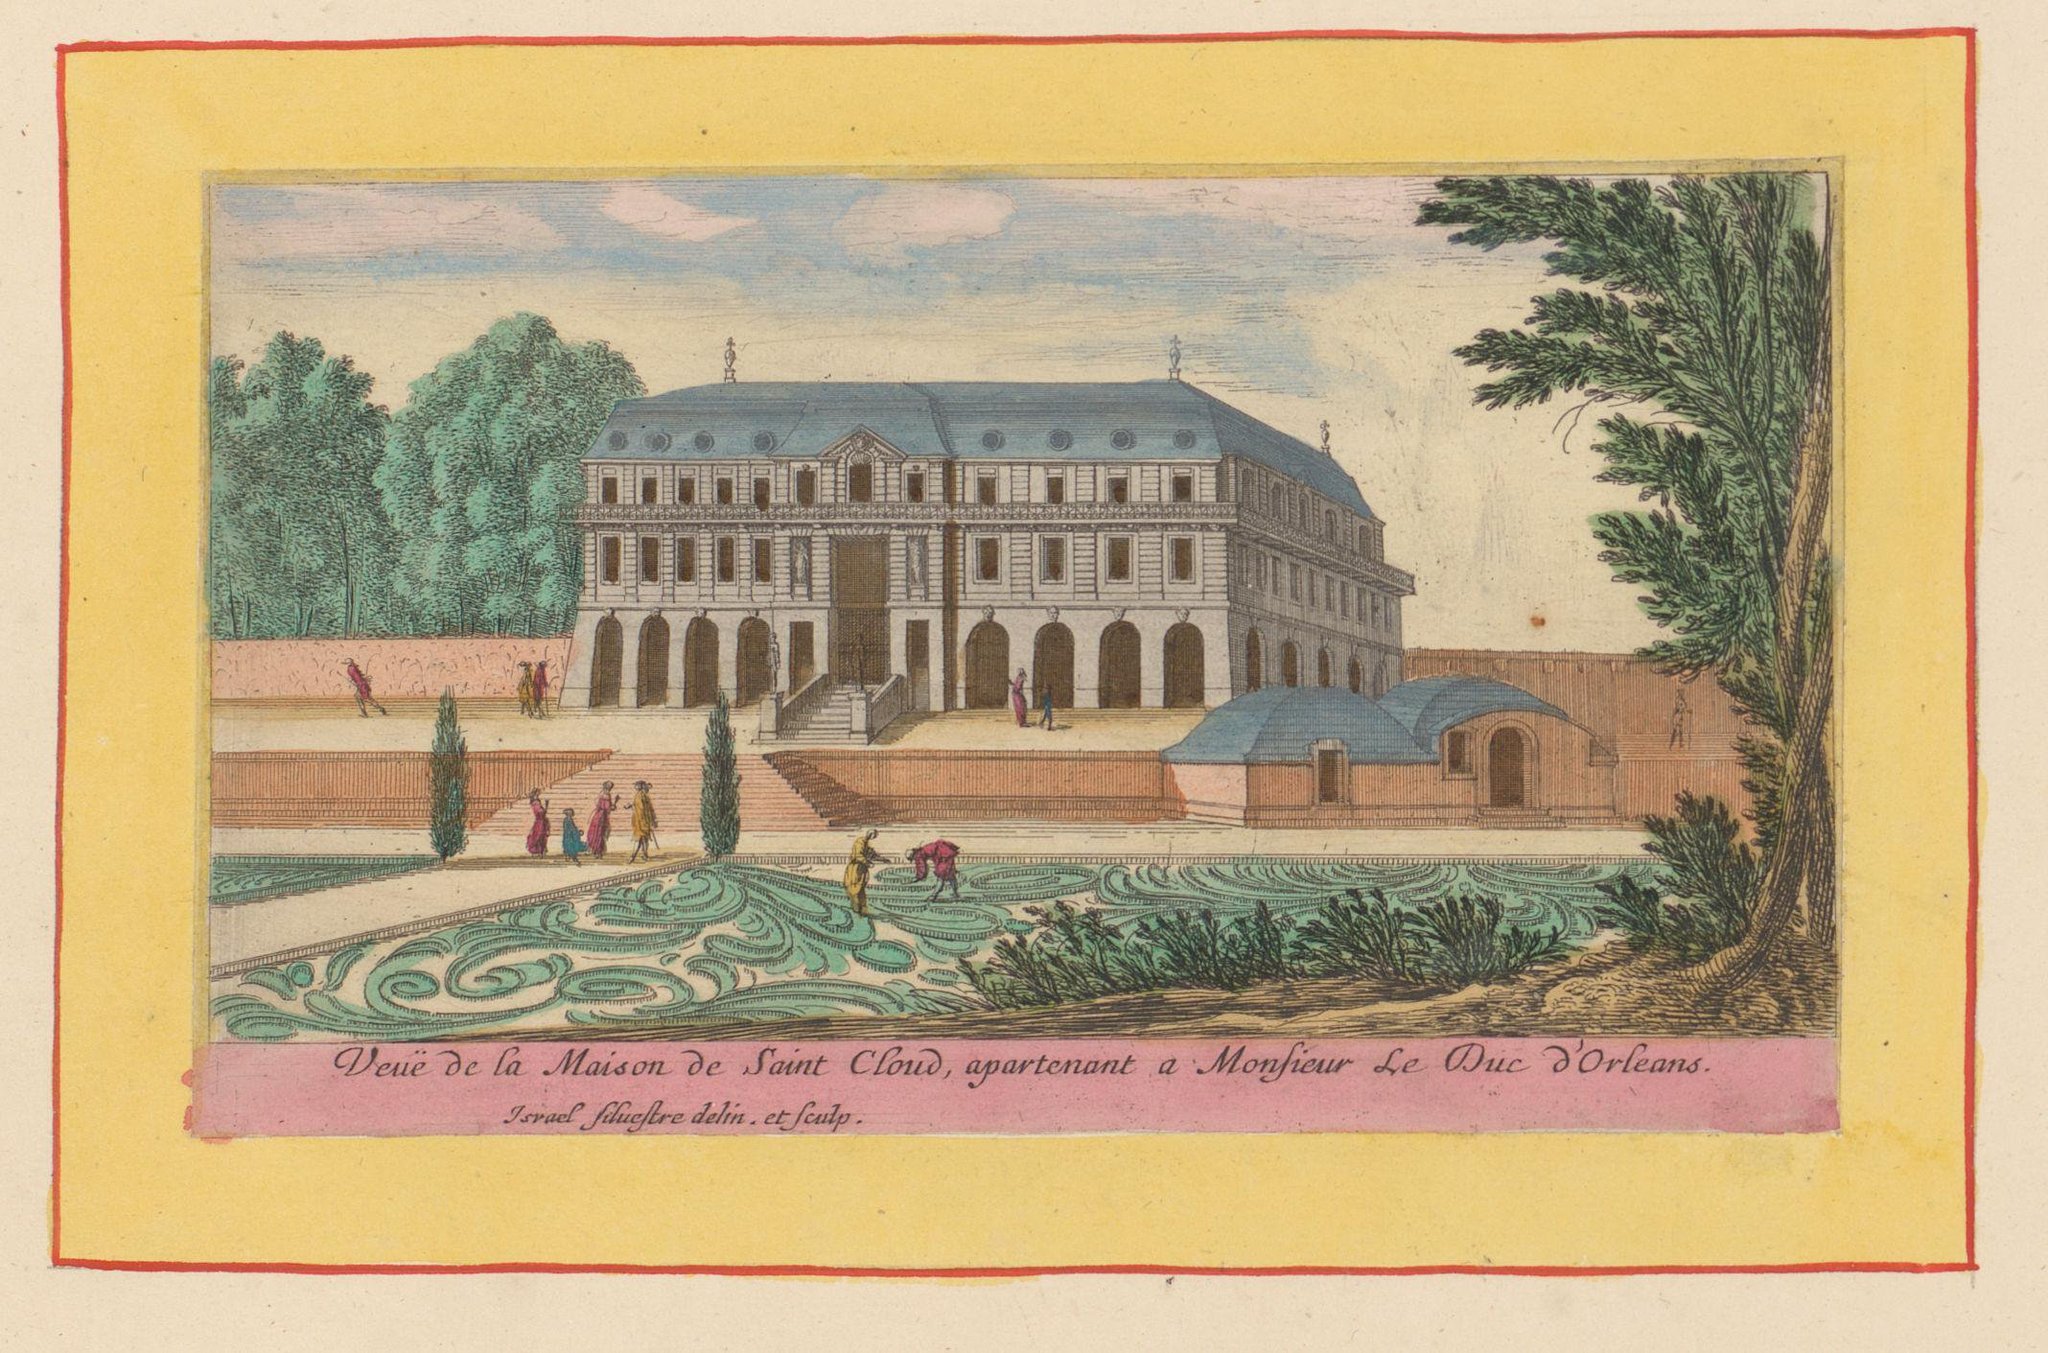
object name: album leaf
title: Veuë de la Maison de Saint Cloud, apartenant a Monsieur Le Duc d'Orleans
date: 1631-1691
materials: paper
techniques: etching, hand coloring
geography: the hague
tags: castle, french or architectonic garden; formal garden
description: Gezicht op Château de Saint-Cloud, de residentie van de hertog van Orléans. Prent maakt deel uit van een album.